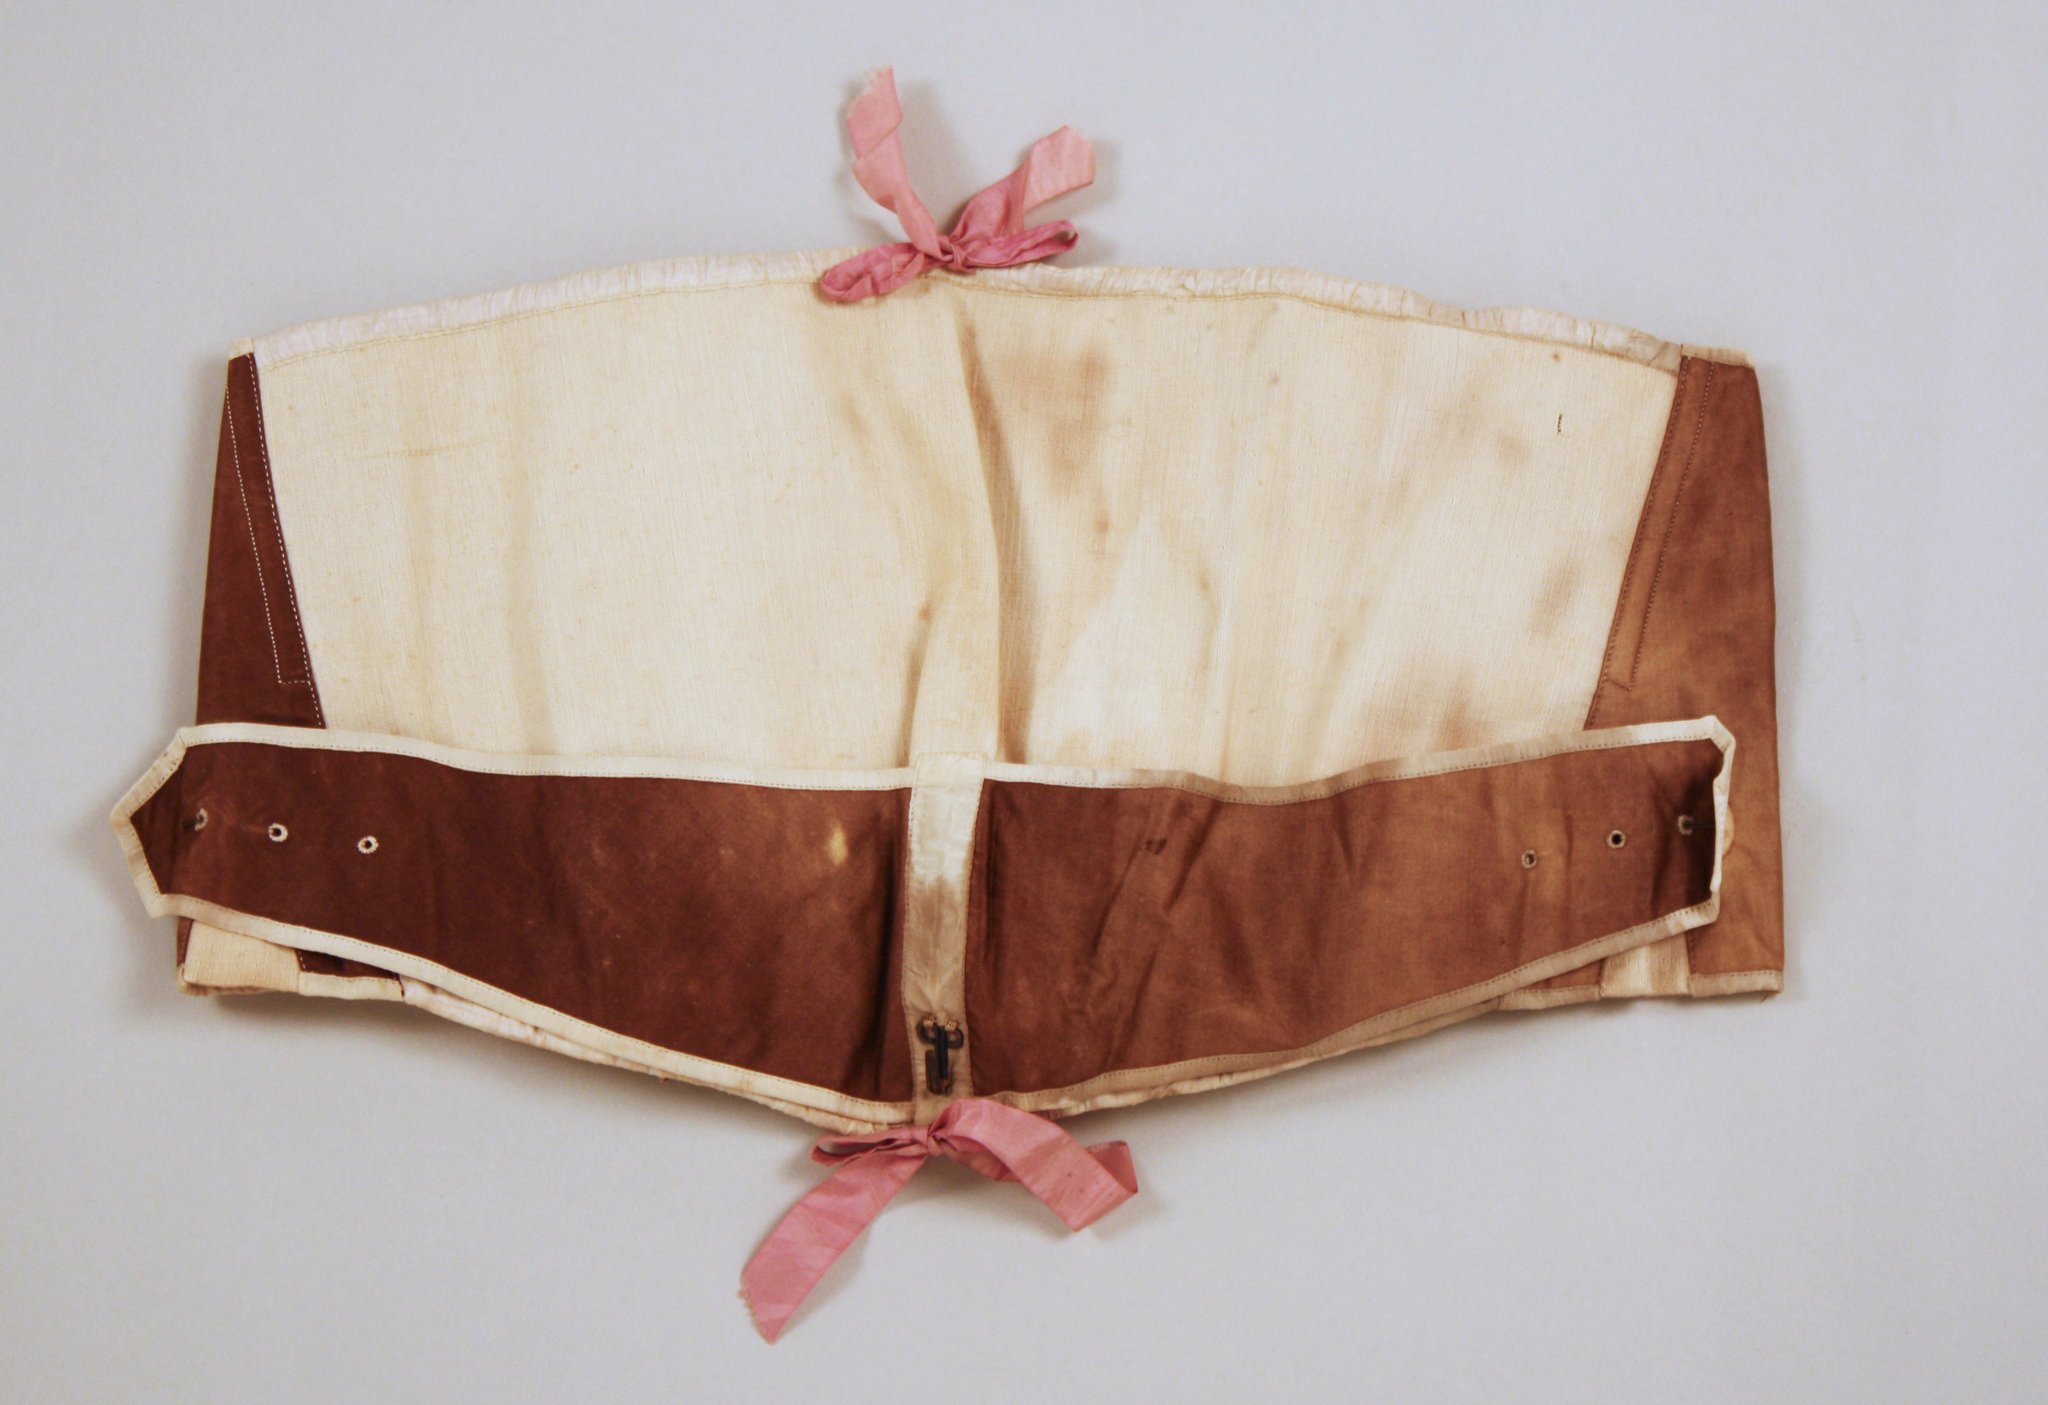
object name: abdominal supporter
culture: british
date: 1850-1879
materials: bone, cotton, linen, metal, silk